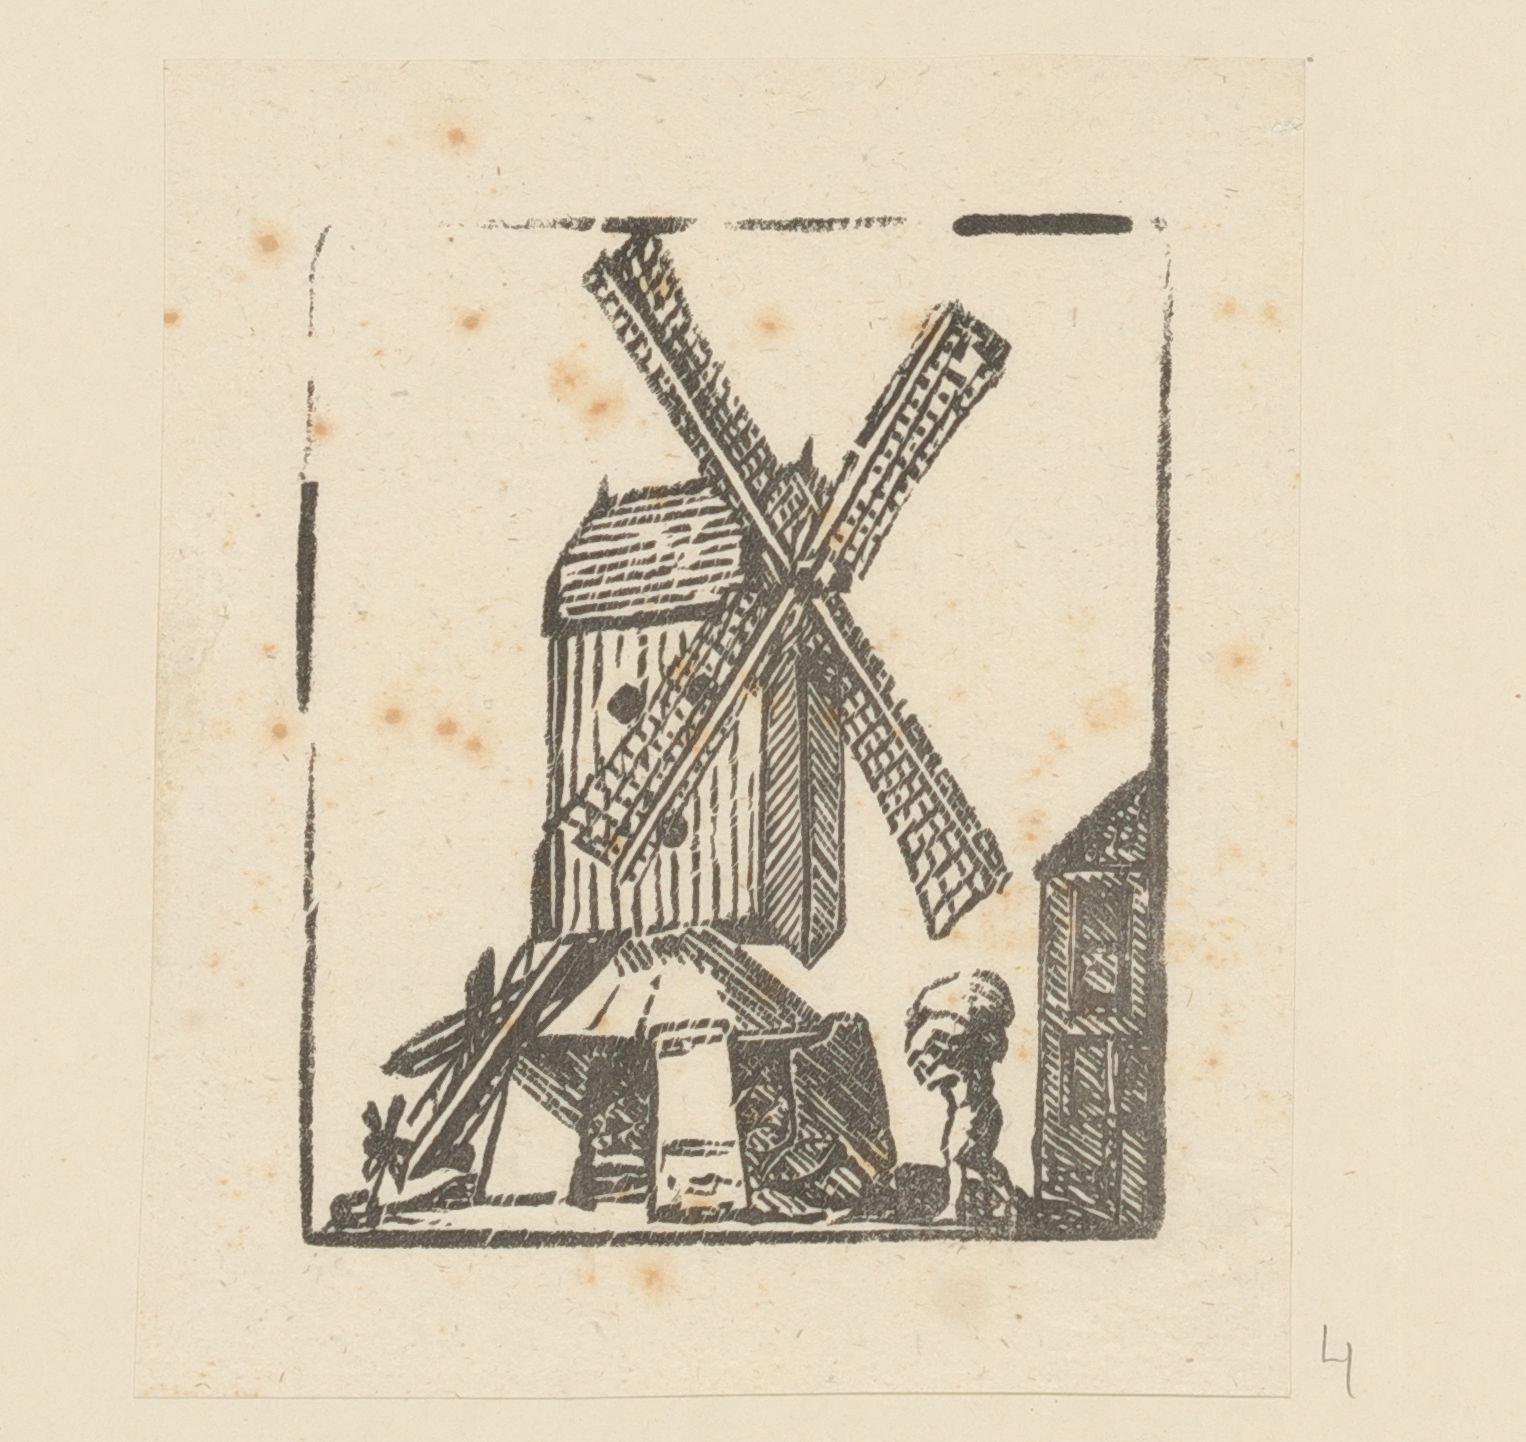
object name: print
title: Molen met molenaar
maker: Anonymous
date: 1778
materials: paper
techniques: woodcut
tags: miller, windmill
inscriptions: stamp, stamp, collector's mark: Lugt 1641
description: Onderwerpsrubrieken binnen de Atlas Zeden en Gewoonten: Onderwijs en Wetenschappen, Opvoeding en Onderwijs, Haneboeken en schoolprenten.